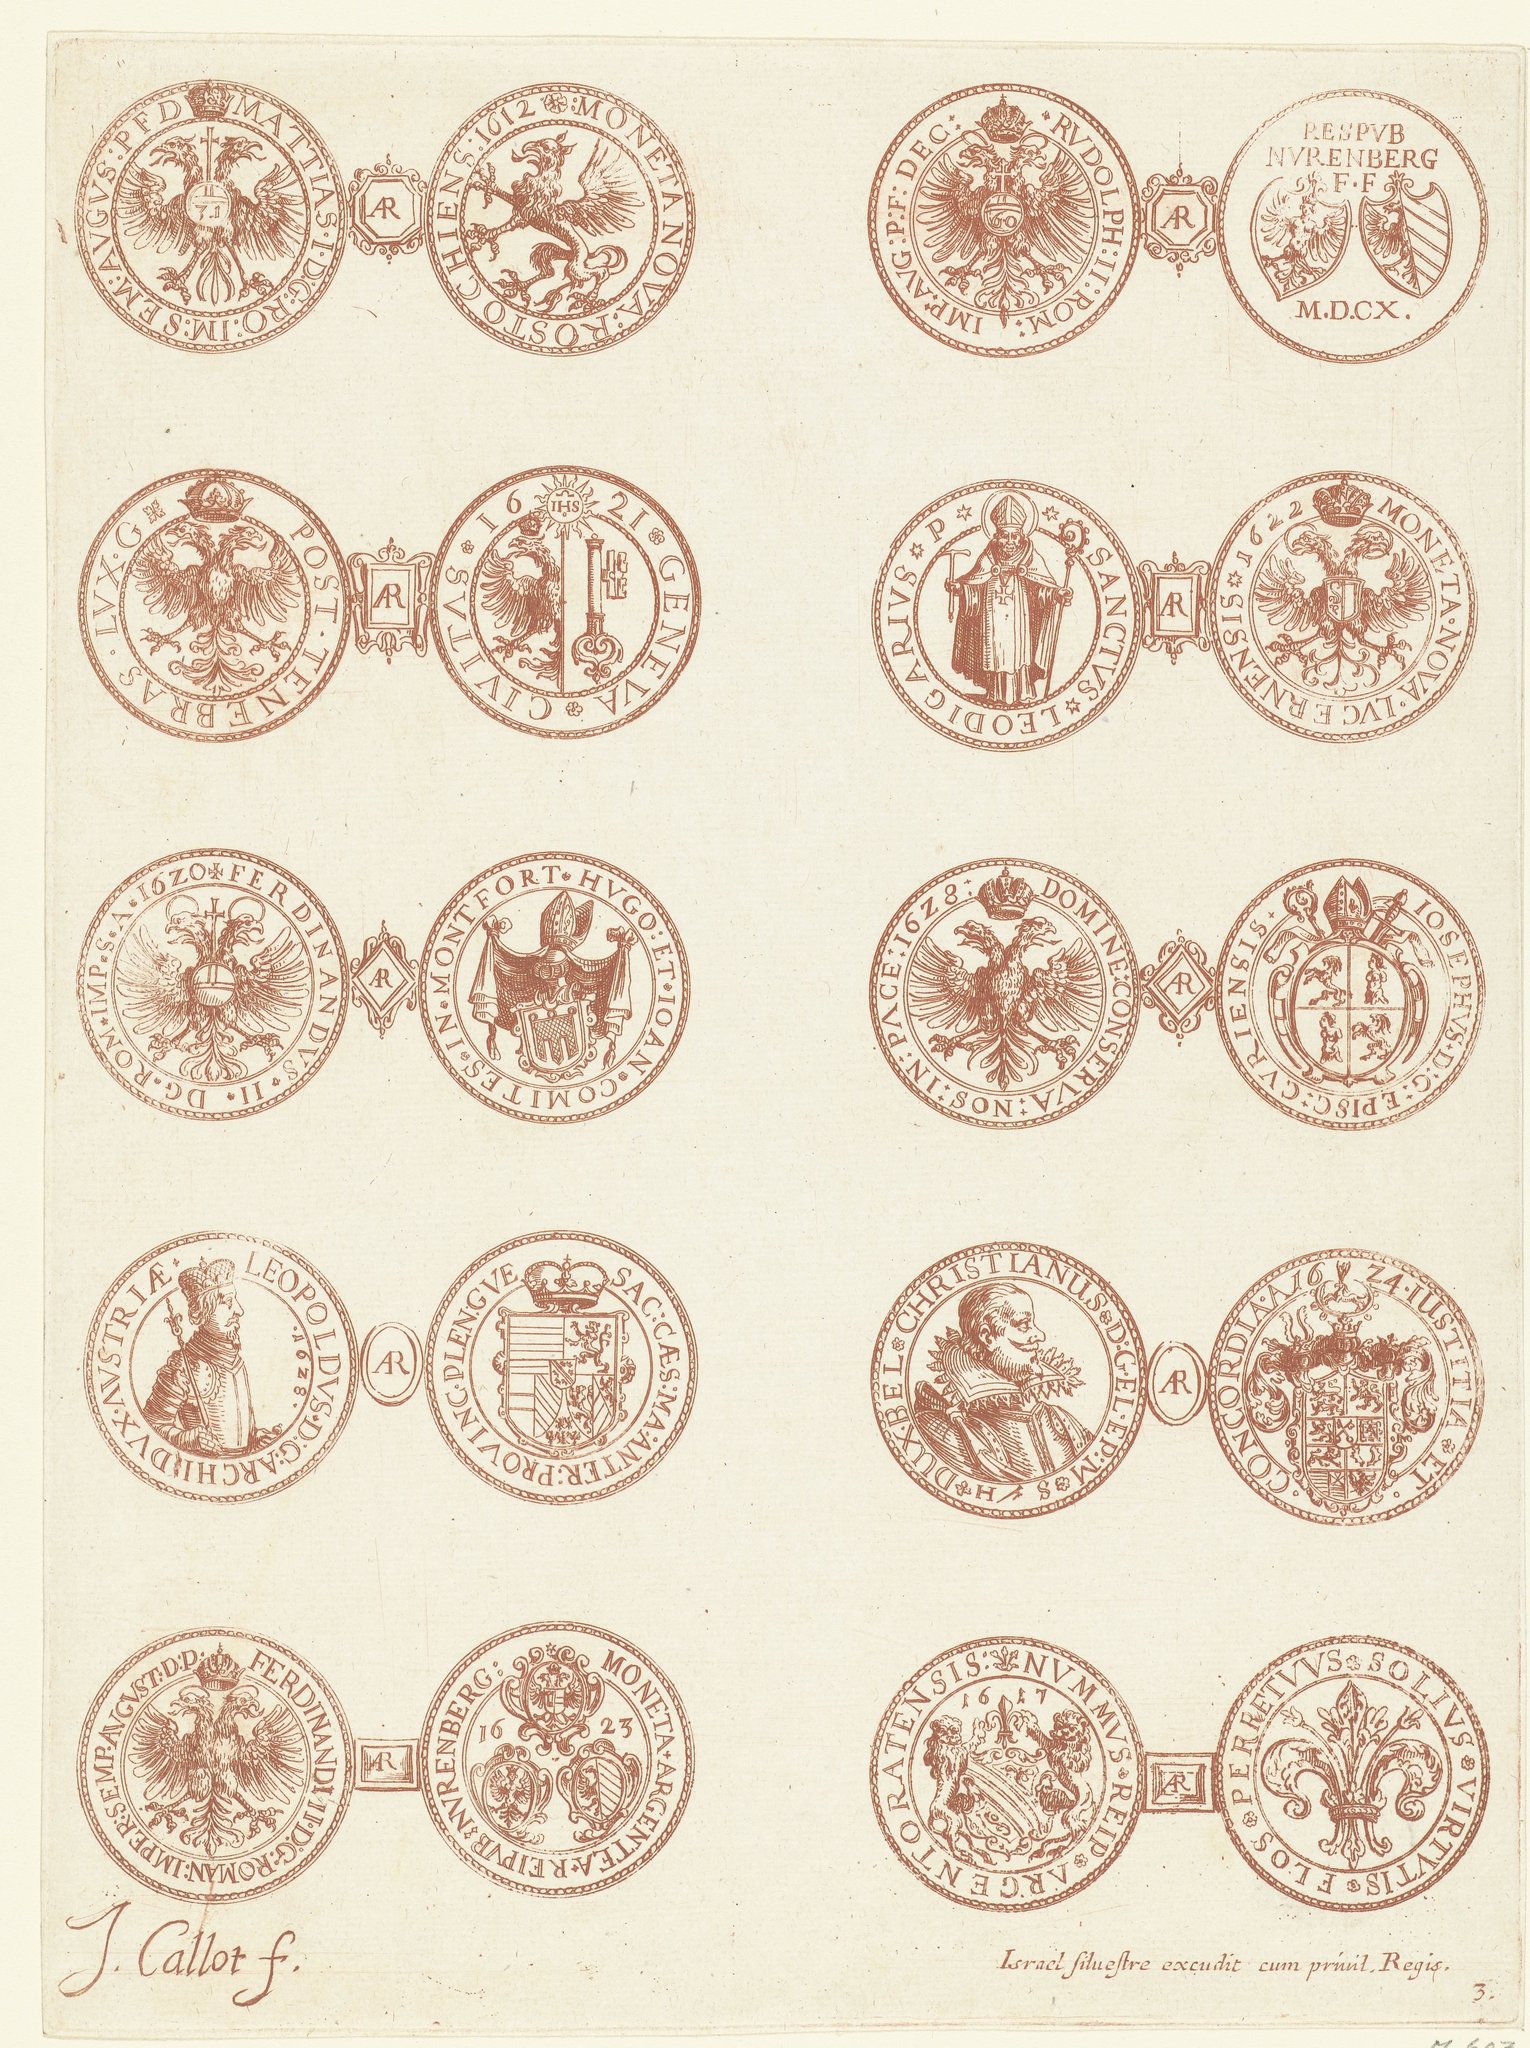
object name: print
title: Europese munten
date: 1629-1630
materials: paper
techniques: etching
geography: paris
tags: coin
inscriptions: collector's mark: Lugt 240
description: Tien Europese munten, in twee kolommen van vijf afgebeeld. Deze prent is onderdeel van een serie van tien prenten met voorstellingen van munten die tussen 1522 en 1629 in omloop gebracht zijn in Europa, voornamelijk in Duitsland en Italië. Van elke munt zijn de voor- en achterzijde naast elkaar weergegeven, verbonden door een cartouche met de letters AR (argentum - zilver) of AV (aureum - goud). De zilveren munten beslaan de eerste negen bladen en een deel van het tiende blad, dat verder voornamelijk gouden munten toont.